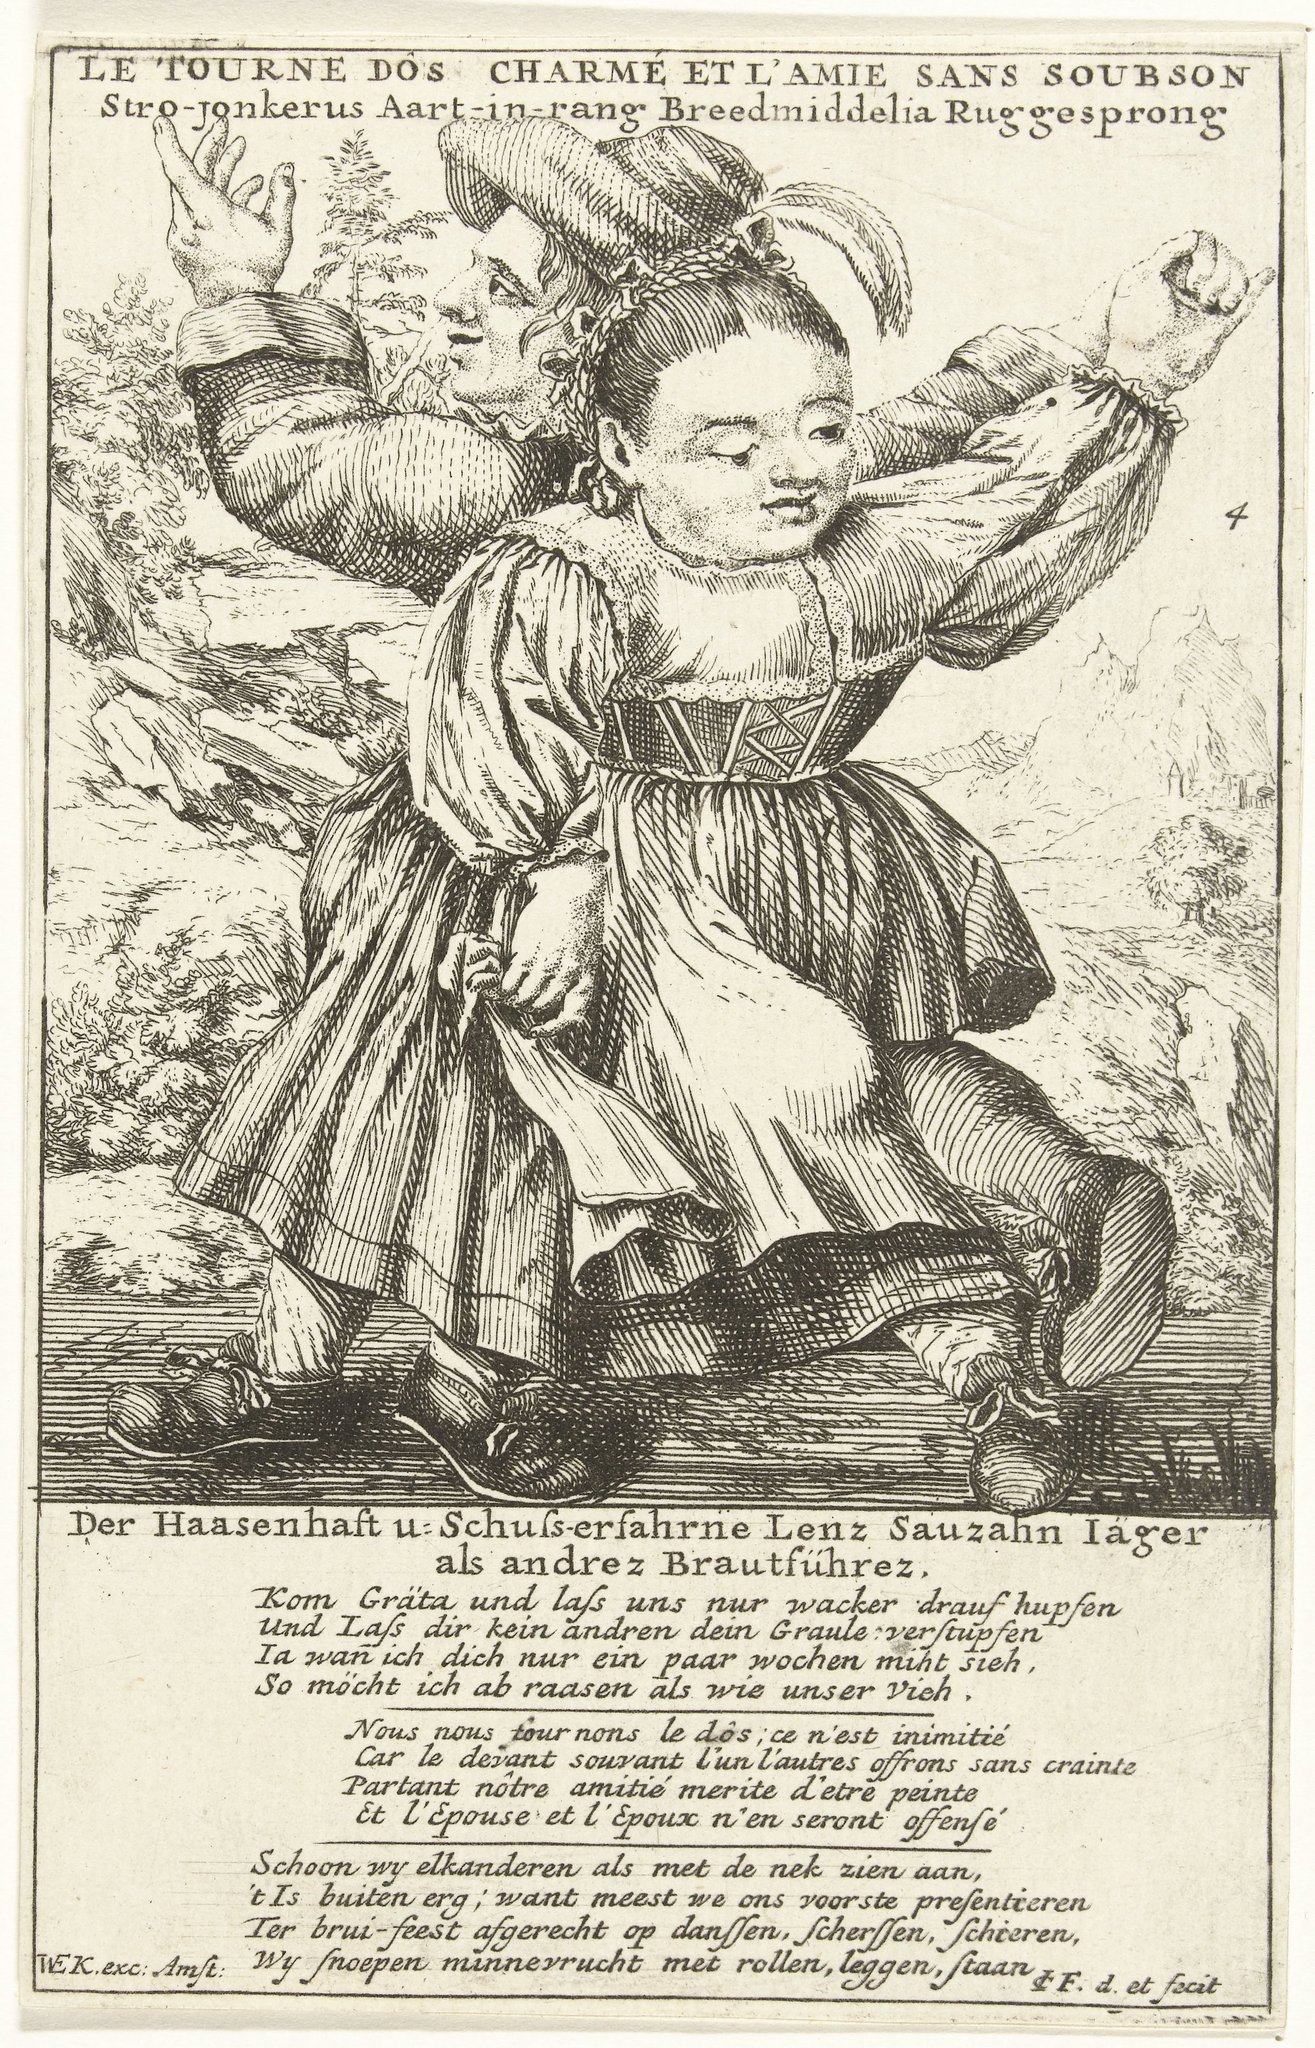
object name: print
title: Dansend paar kleine mensen, ca. 1720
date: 1718-1720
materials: paper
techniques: etching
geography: amsterdam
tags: caricatures (human types), little people, one pair dancing; man and woman dancing as a couple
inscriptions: collector's mark: Lugt 2228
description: Dansend paar kleine mensen. In het onderschrift verzen (met seksuele toespelingen) in het Duits, Frans en Nederlands. Genummerd rechts midden: 4. Onderdeel van deel IV (een serie van zes platen van dansende paren op een bruiloftsfeest) in de tweede Nederlandse gebonden uitgave uit 1720 (en deels gerelateerd aan de Windhandel in dat jaar) van een serie karikaturen van kleine mensen, bekend als Het Dwergentooneel.